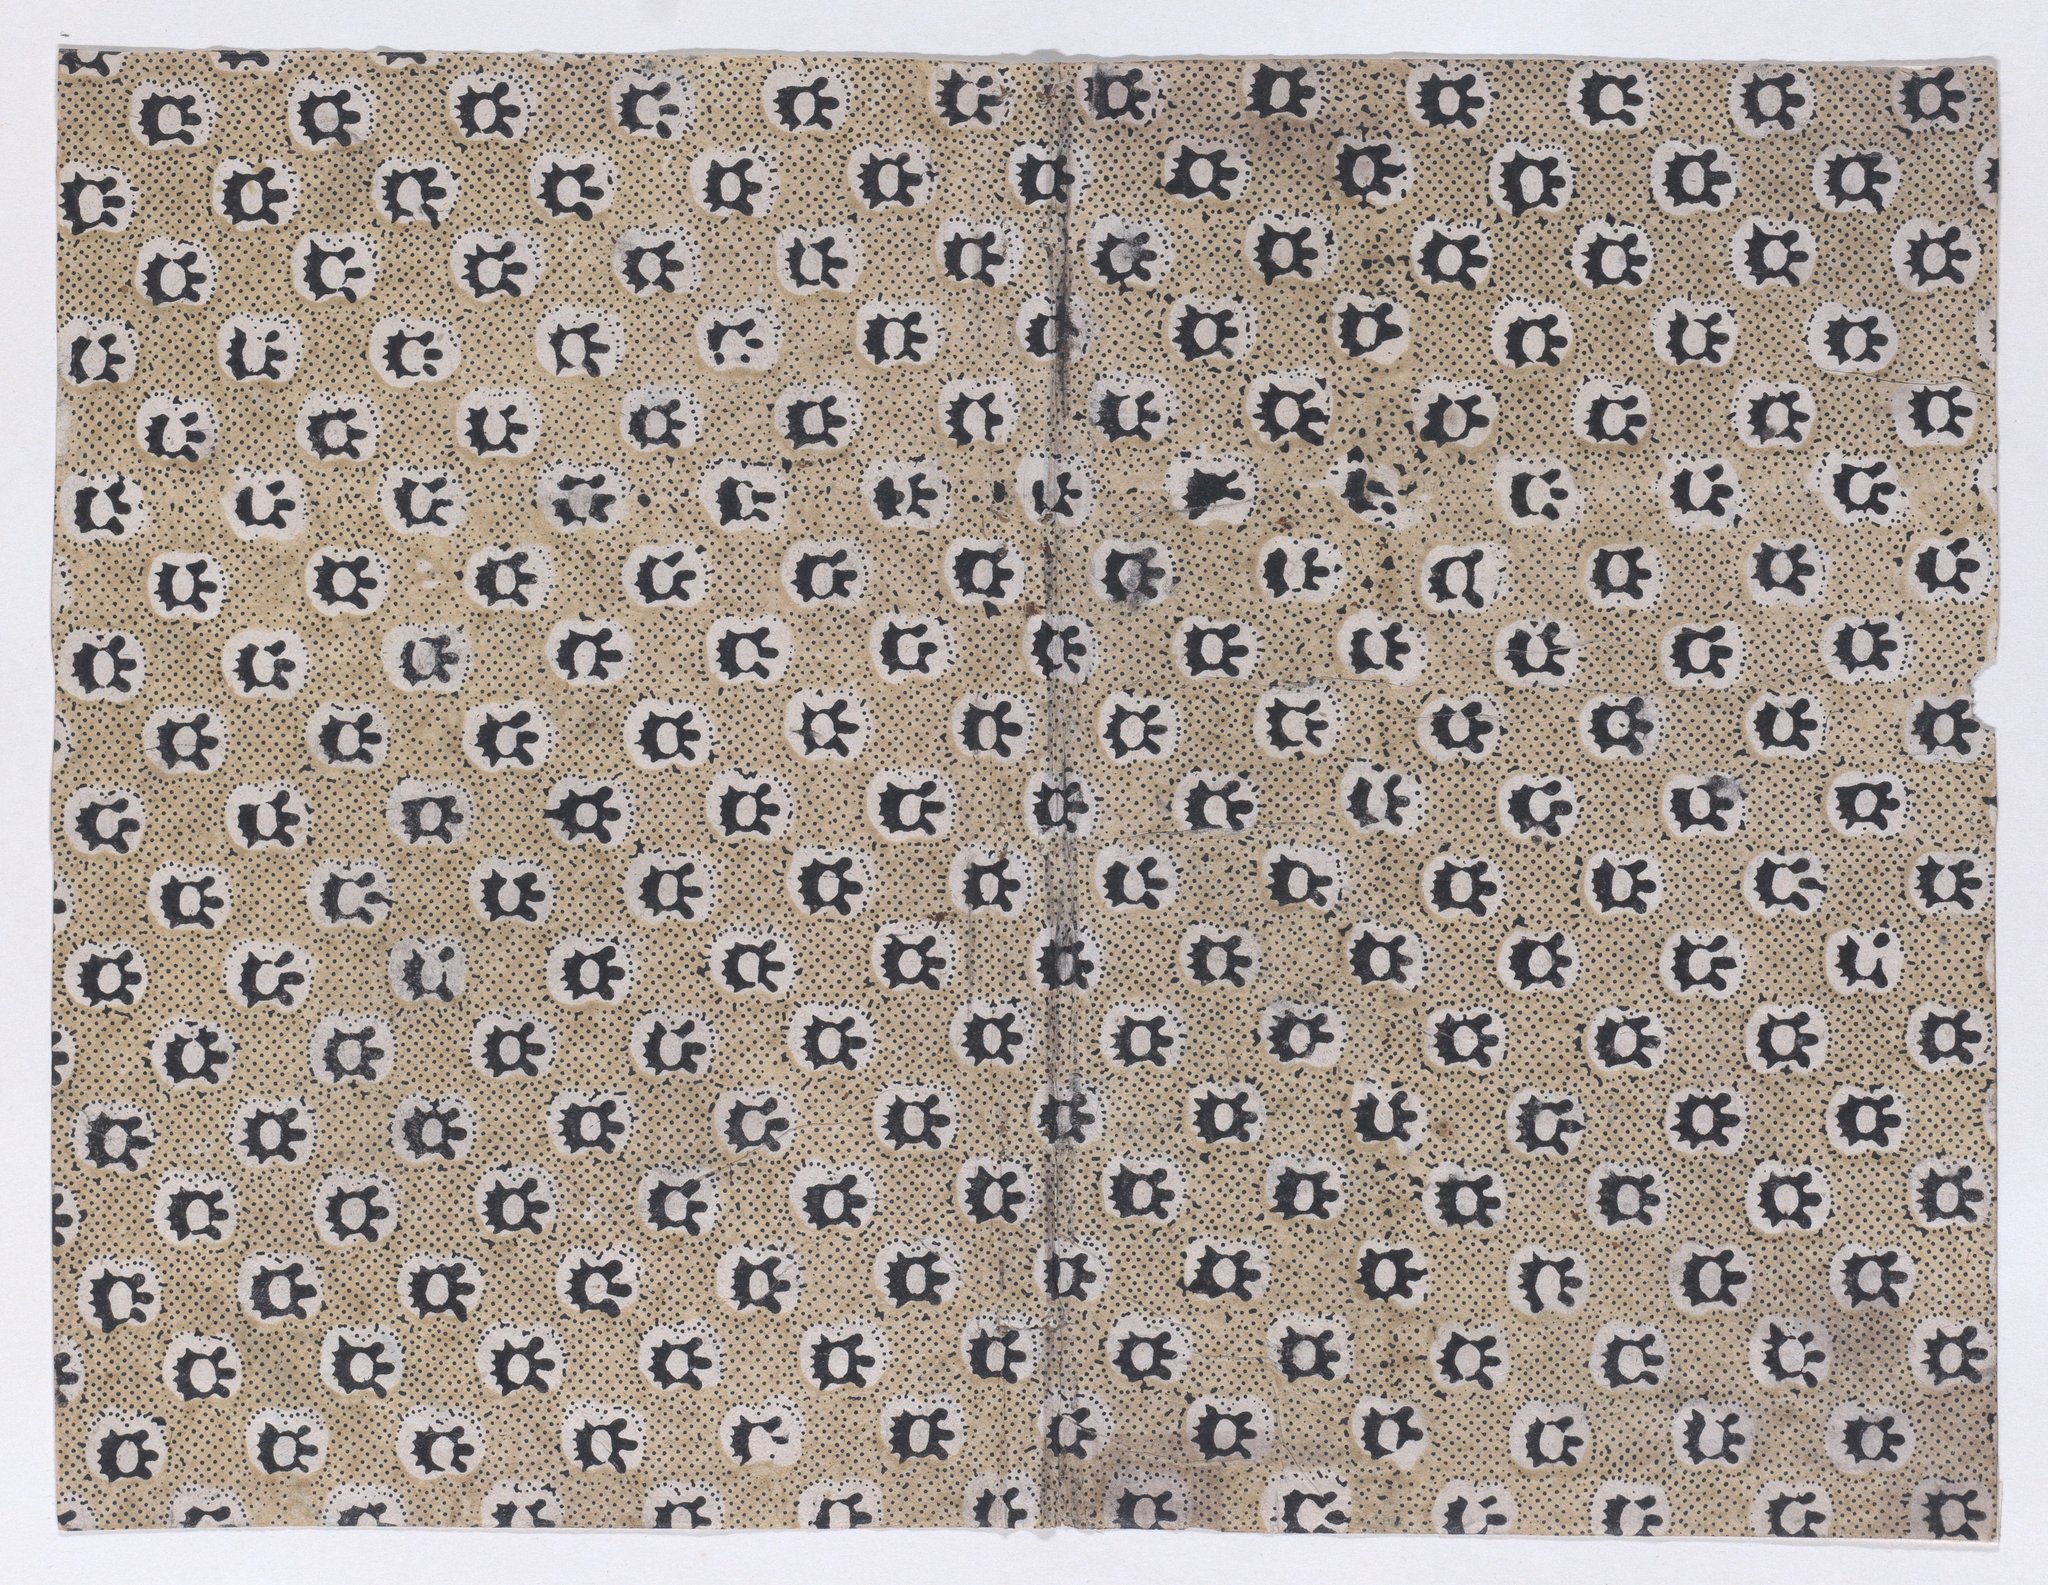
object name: print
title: Book cover with overall dot and abstract pattern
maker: Anonymous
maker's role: artist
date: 1801-1900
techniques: relief print